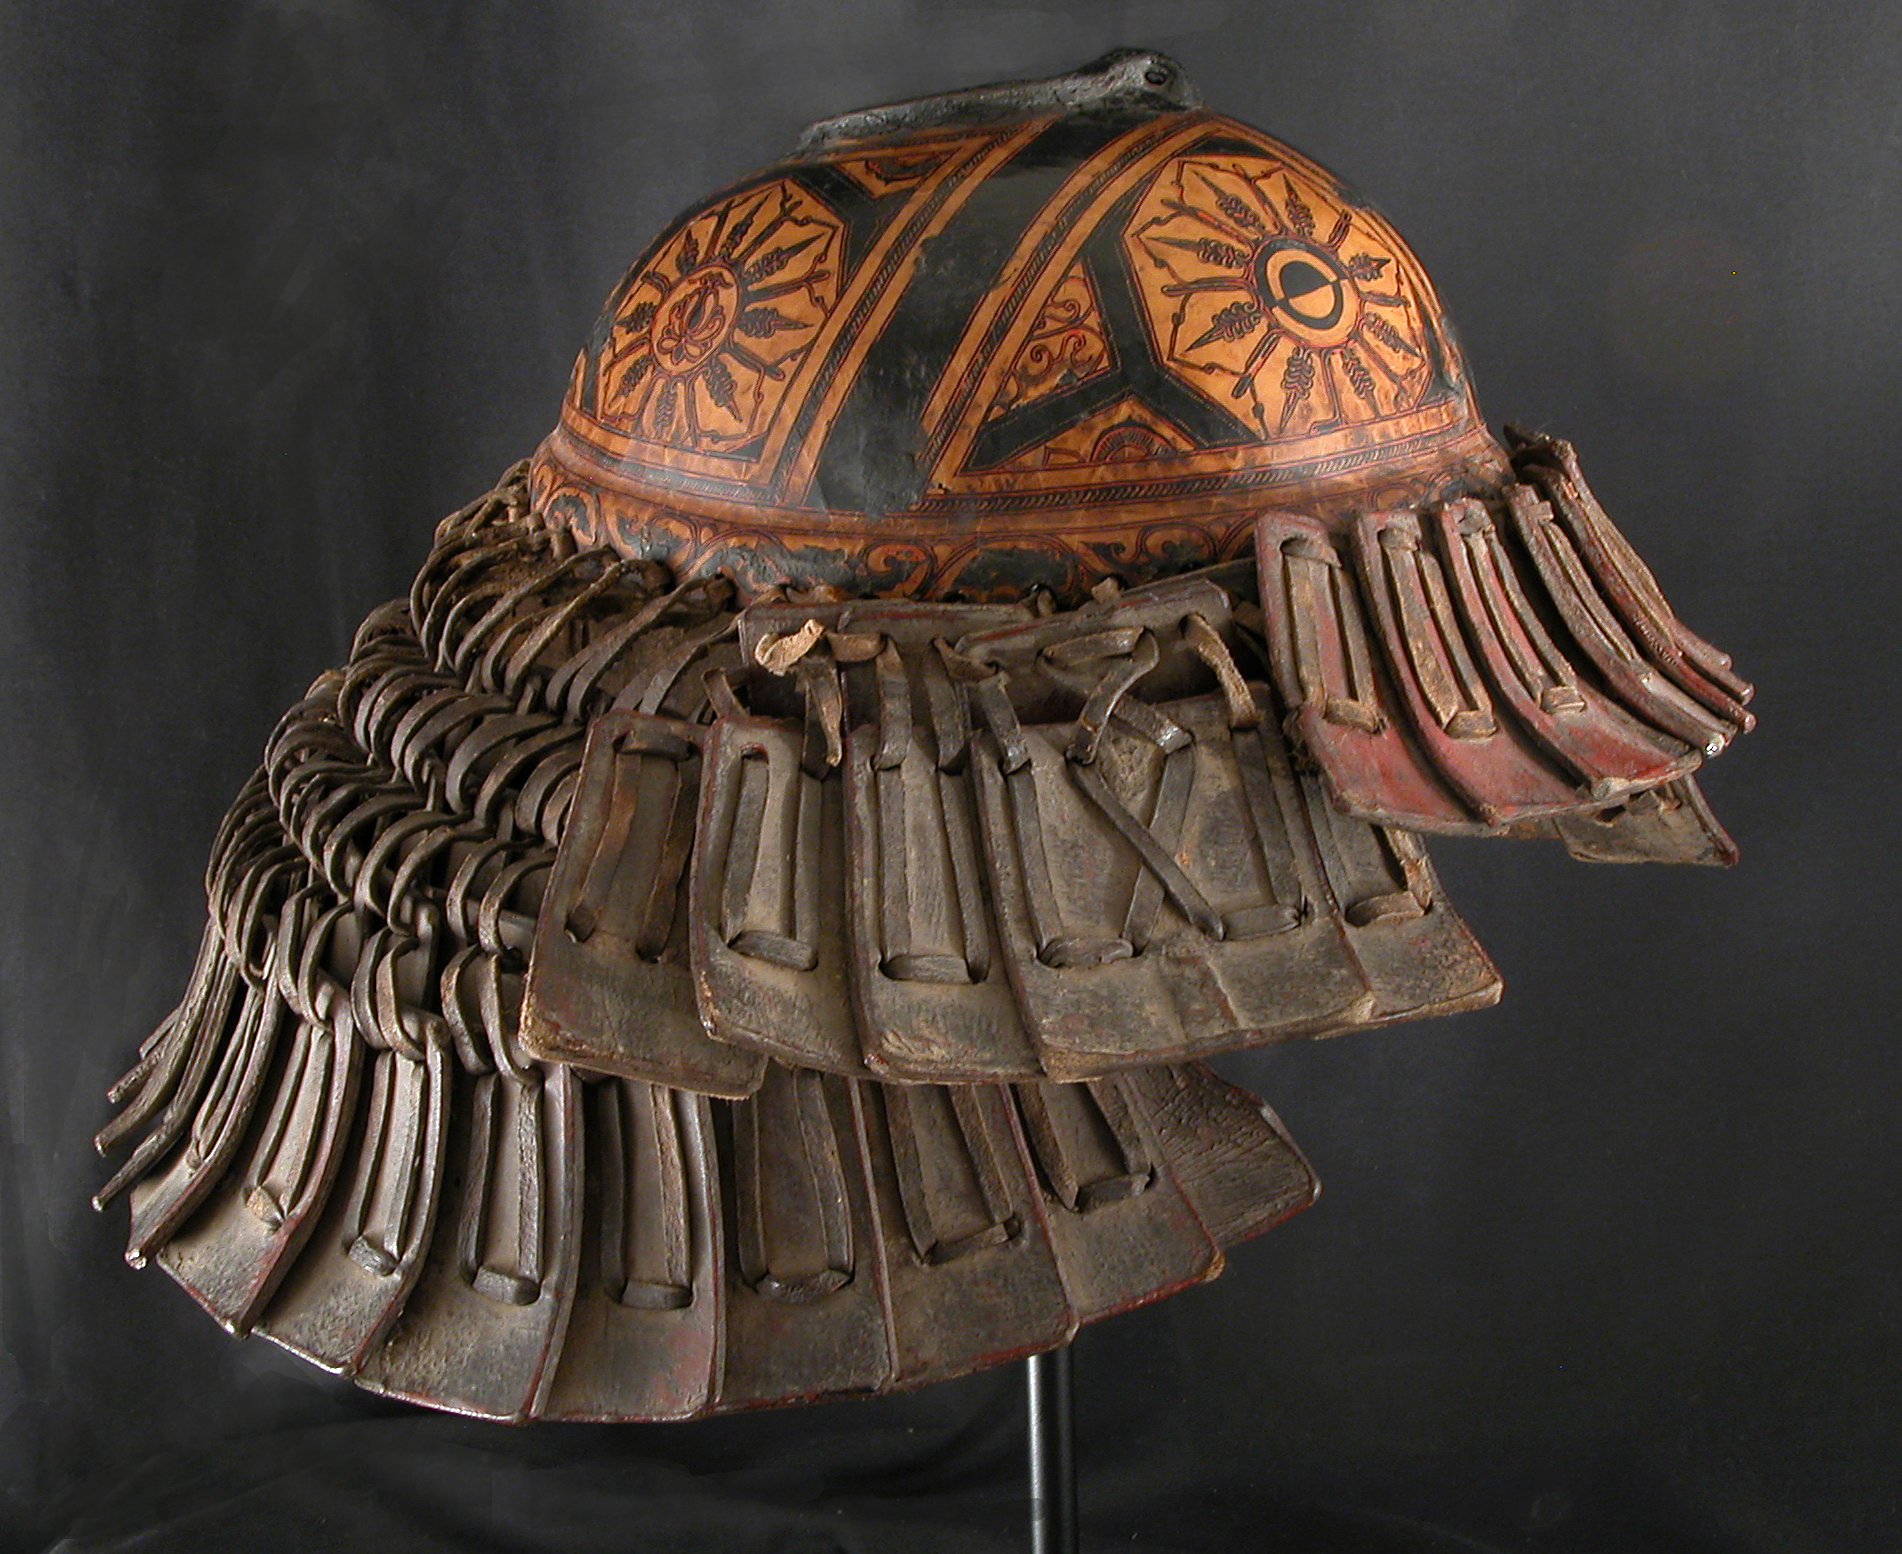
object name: helmet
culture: yi or nuosu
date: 1601-1700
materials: lacquer, leather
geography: china